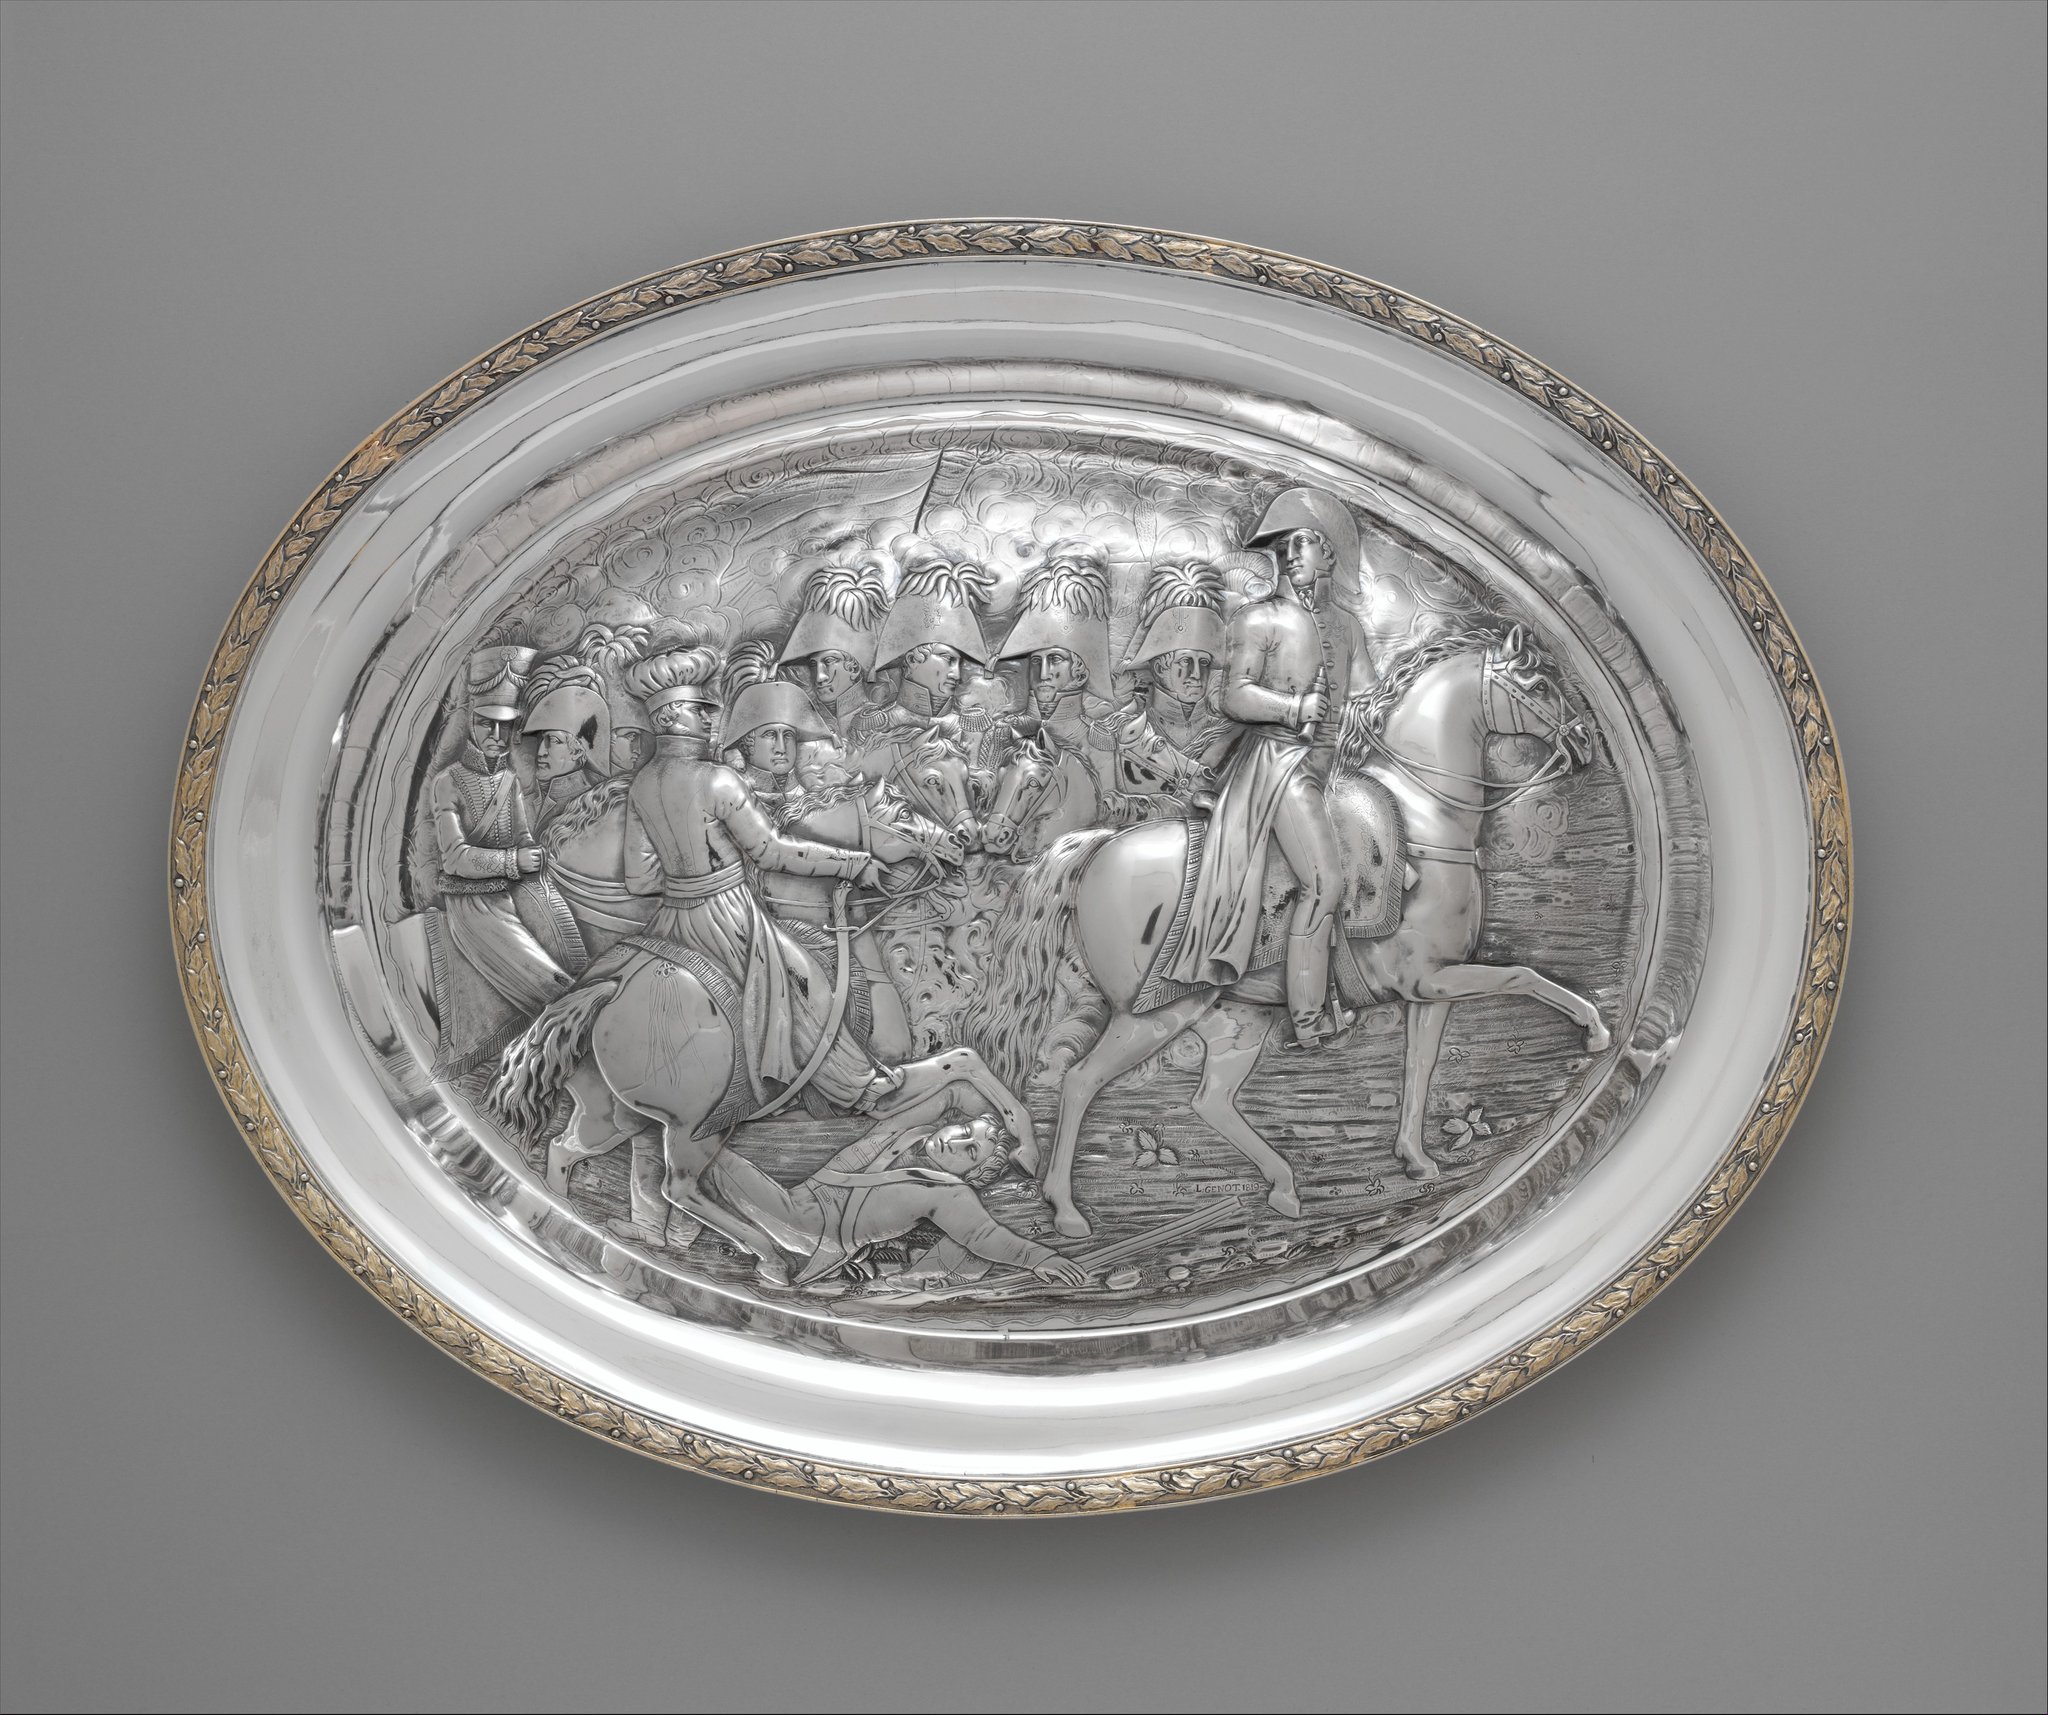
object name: plateau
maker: richard sibley i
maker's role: maker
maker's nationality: british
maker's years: 1793-1836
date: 1831-1832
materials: silver gilt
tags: soldiers,men,horses